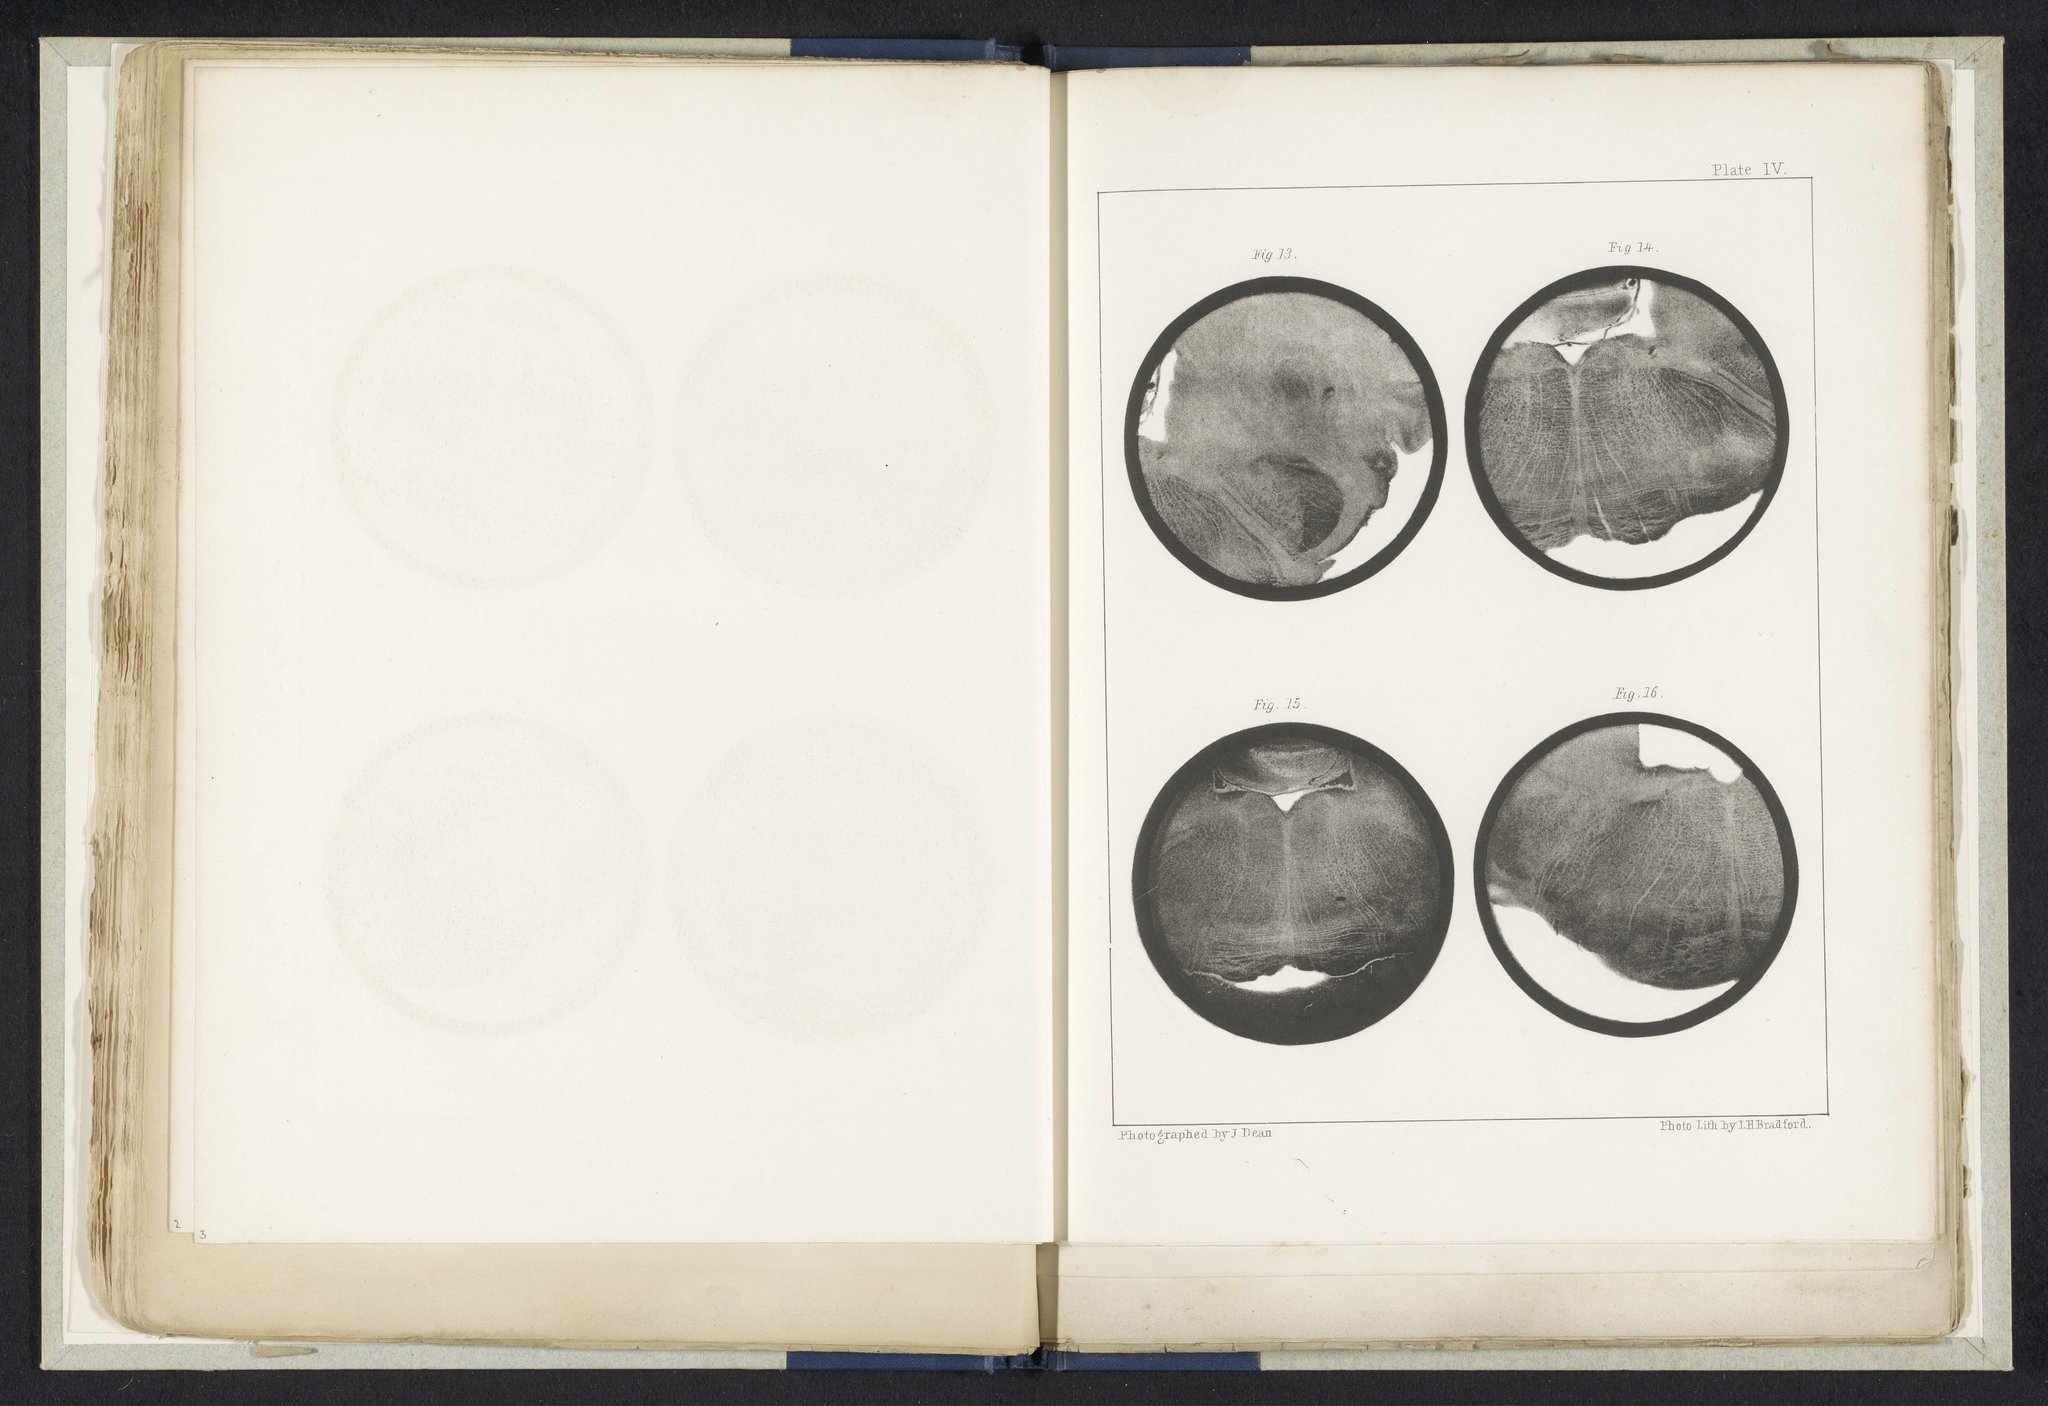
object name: page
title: Vier details van een medulla oblongata van een schaap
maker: john dean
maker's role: fotograaf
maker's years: 1831-1888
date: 1854-1864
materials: paper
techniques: photolithography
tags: brains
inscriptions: number: ‘Plate IV. Fig. 13. Fig 14. Fig. 15. Fig. 16.’